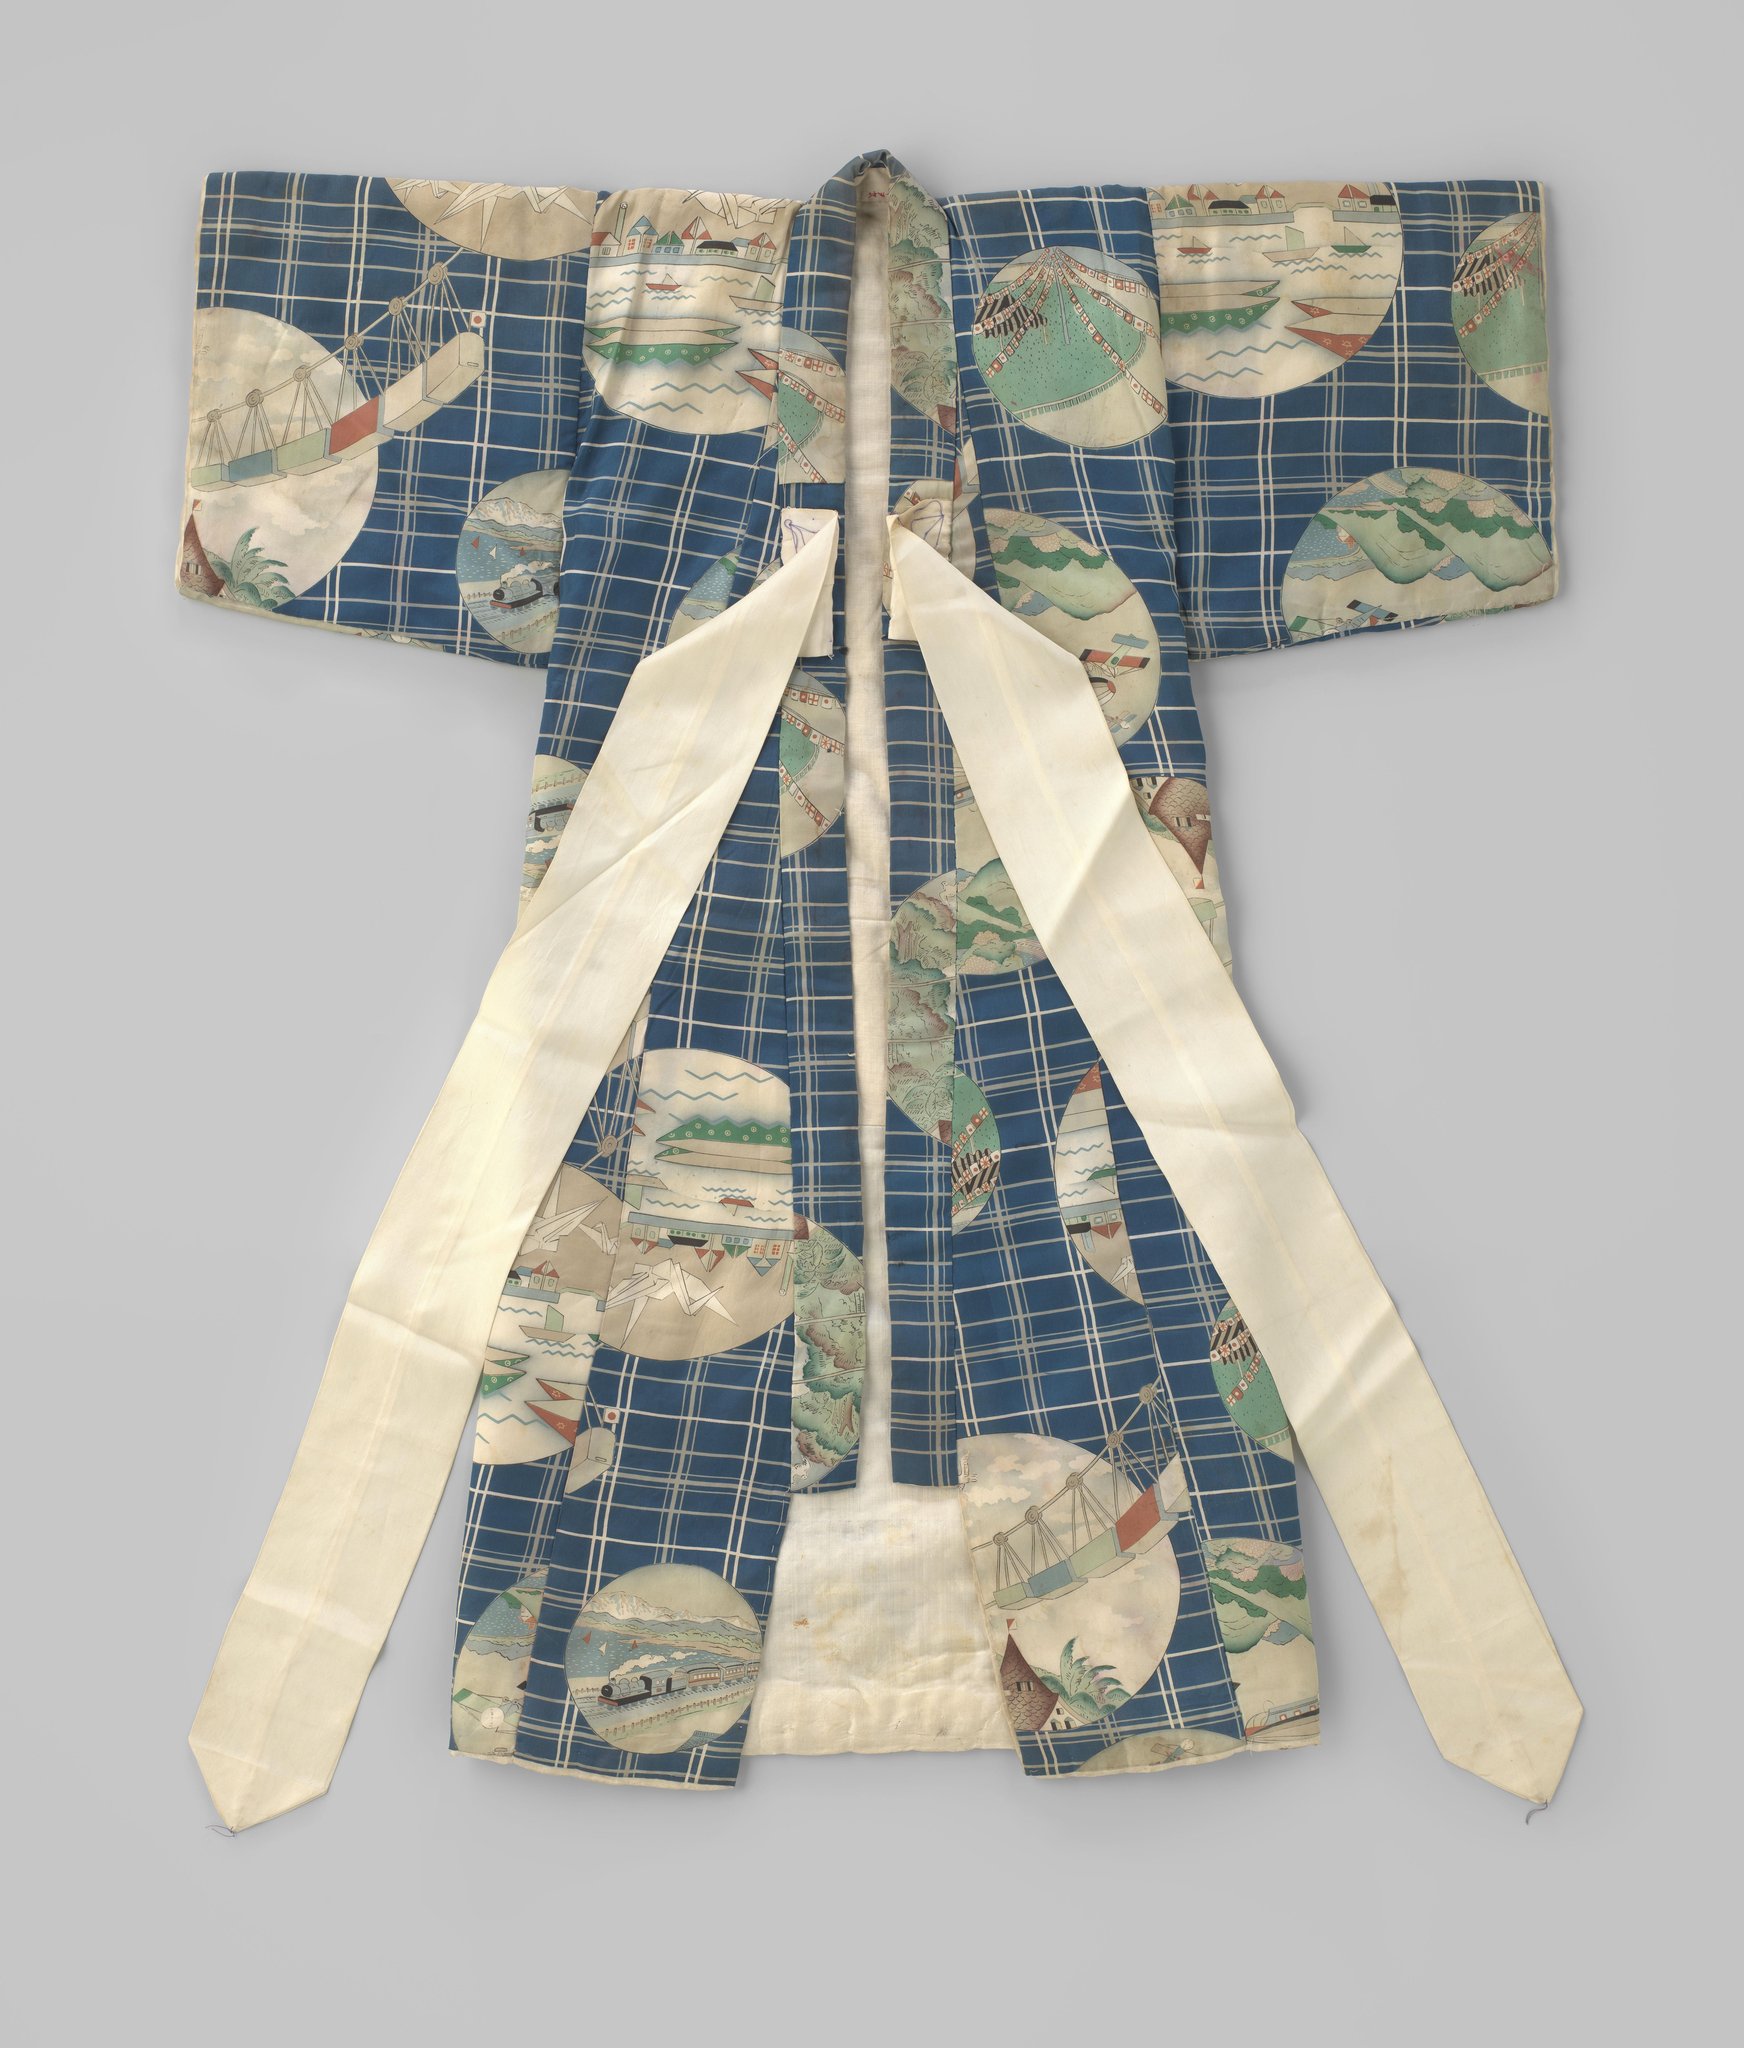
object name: kimono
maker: Anonymous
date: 1920-1940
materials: silk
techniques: painting, weave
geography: japan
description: Kimonos: Mirrors of a Man’s Life. The kimonos on view here afford a glimpse into the lives of Japanese men from around the 1910s to the 1950s, from childhood to adulthood. This was a period of great change for Japan, marked by increasing industrialization and political conflicts culminating in the Second World War. Life modernized, technology advanced, and people took up new hobbies. Traditionally, men’s outer clothing tended to be reserved and a solid colour. Clothes could nevertheless also be a medium for highly unusual depictions which, however, were not visible to everyone. While motifs adorned the exterior of children’s garments, they were hidden from view in those worn by adult men. The decoration was found on the inside: on a long under garment, or the lining of a jacket (haori). This concealed imagery divulges the lives of the owners at the beginning of the 20th century. Childhood. A kimono marked events and stages in a man’s life. The kimonos on the top row (except the two everyday ones at either end) were worn by boys during the religious ceremony of miyamairi, namely an infant’s first visit to a Shinto shrine. This event followed a prescribed ritual and was an important and formative moment in the life of a Japanese man. Clothing for boys enveloped them in images that were to become part of their identity. The depictions included motifs that were considered gender and age appropriate: toys, manly hobbies, stories of heroic battles, technology, and so forth. Broader themes such as military conflicts and nationalism also filtered into children’s daily lives at an early stage. The textile designs of some kimonos combined traditional playthings with toy guns and tanks. Adulthood. What does a kimono tell about its owner and his life? Some men chose subjects from classical culture, such as No or Kabuki theatre, while others preferred themes from contemporary life, such as gramophone records or the new popular sport of baseball. Thus, these garments were a canvas for personal choices, but also for political propaganda and nationalistic messages. Some representations are eccentric or even erotic. Others are more general and linked to political events. All aspects of a man’s inner life are touched on. Portraits of beautiful women and playful dogs contrast with images of war, celebrating victories in China. As these representations were under the outer garments, they remained hidden from the outside world and were thus seen only by the kimono’s owner and his intimates.